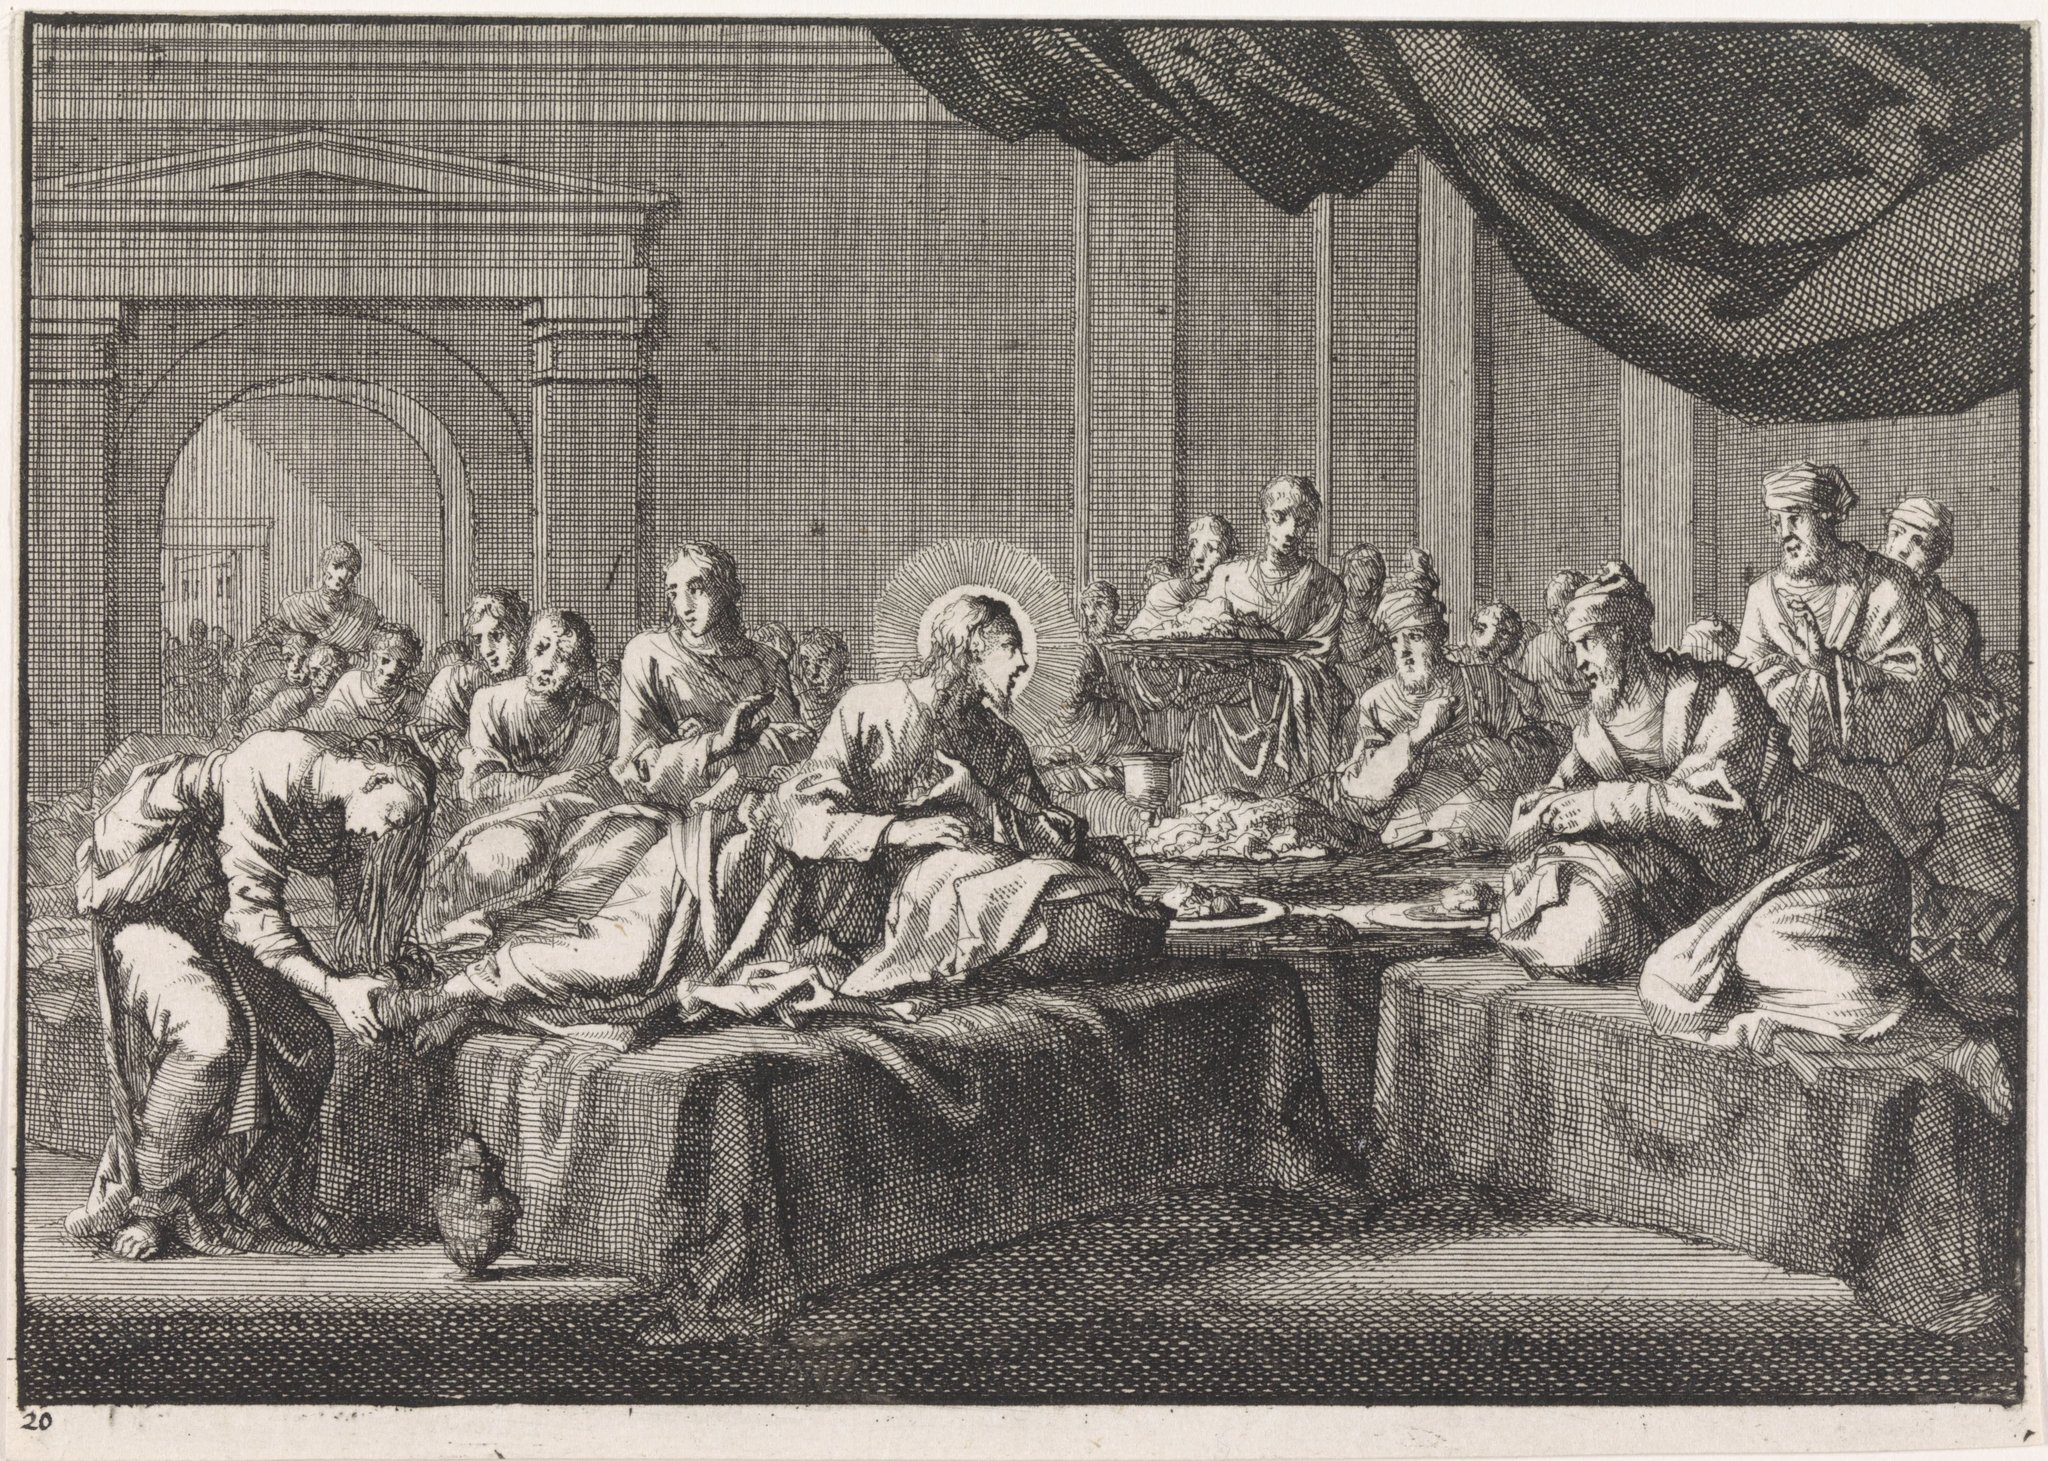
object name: print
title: Maria Magdalena wast de voeten van Christus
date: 1703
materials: paper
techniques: etching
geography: haarlem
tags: a woman washes christ's feet with her tears, and wipes them with her hair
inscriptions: collector's mark: Lugt 2228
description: Proefdruk van een boekillustratie voor David Martin. Historie des Ouden en Nieuwen Testaments. Amsterdam, Pieter Mortier, 1703. Deel II. De boekillustraties voor de Mortierbijbel hebben verschillende staten en kopieën, waarbij de chronologische volgorde moeilijk te achterhalen valt. Als boekillustraties werden ze bovendien herhaaldelijk opnieuw gebruikt voor andere boekwerken.